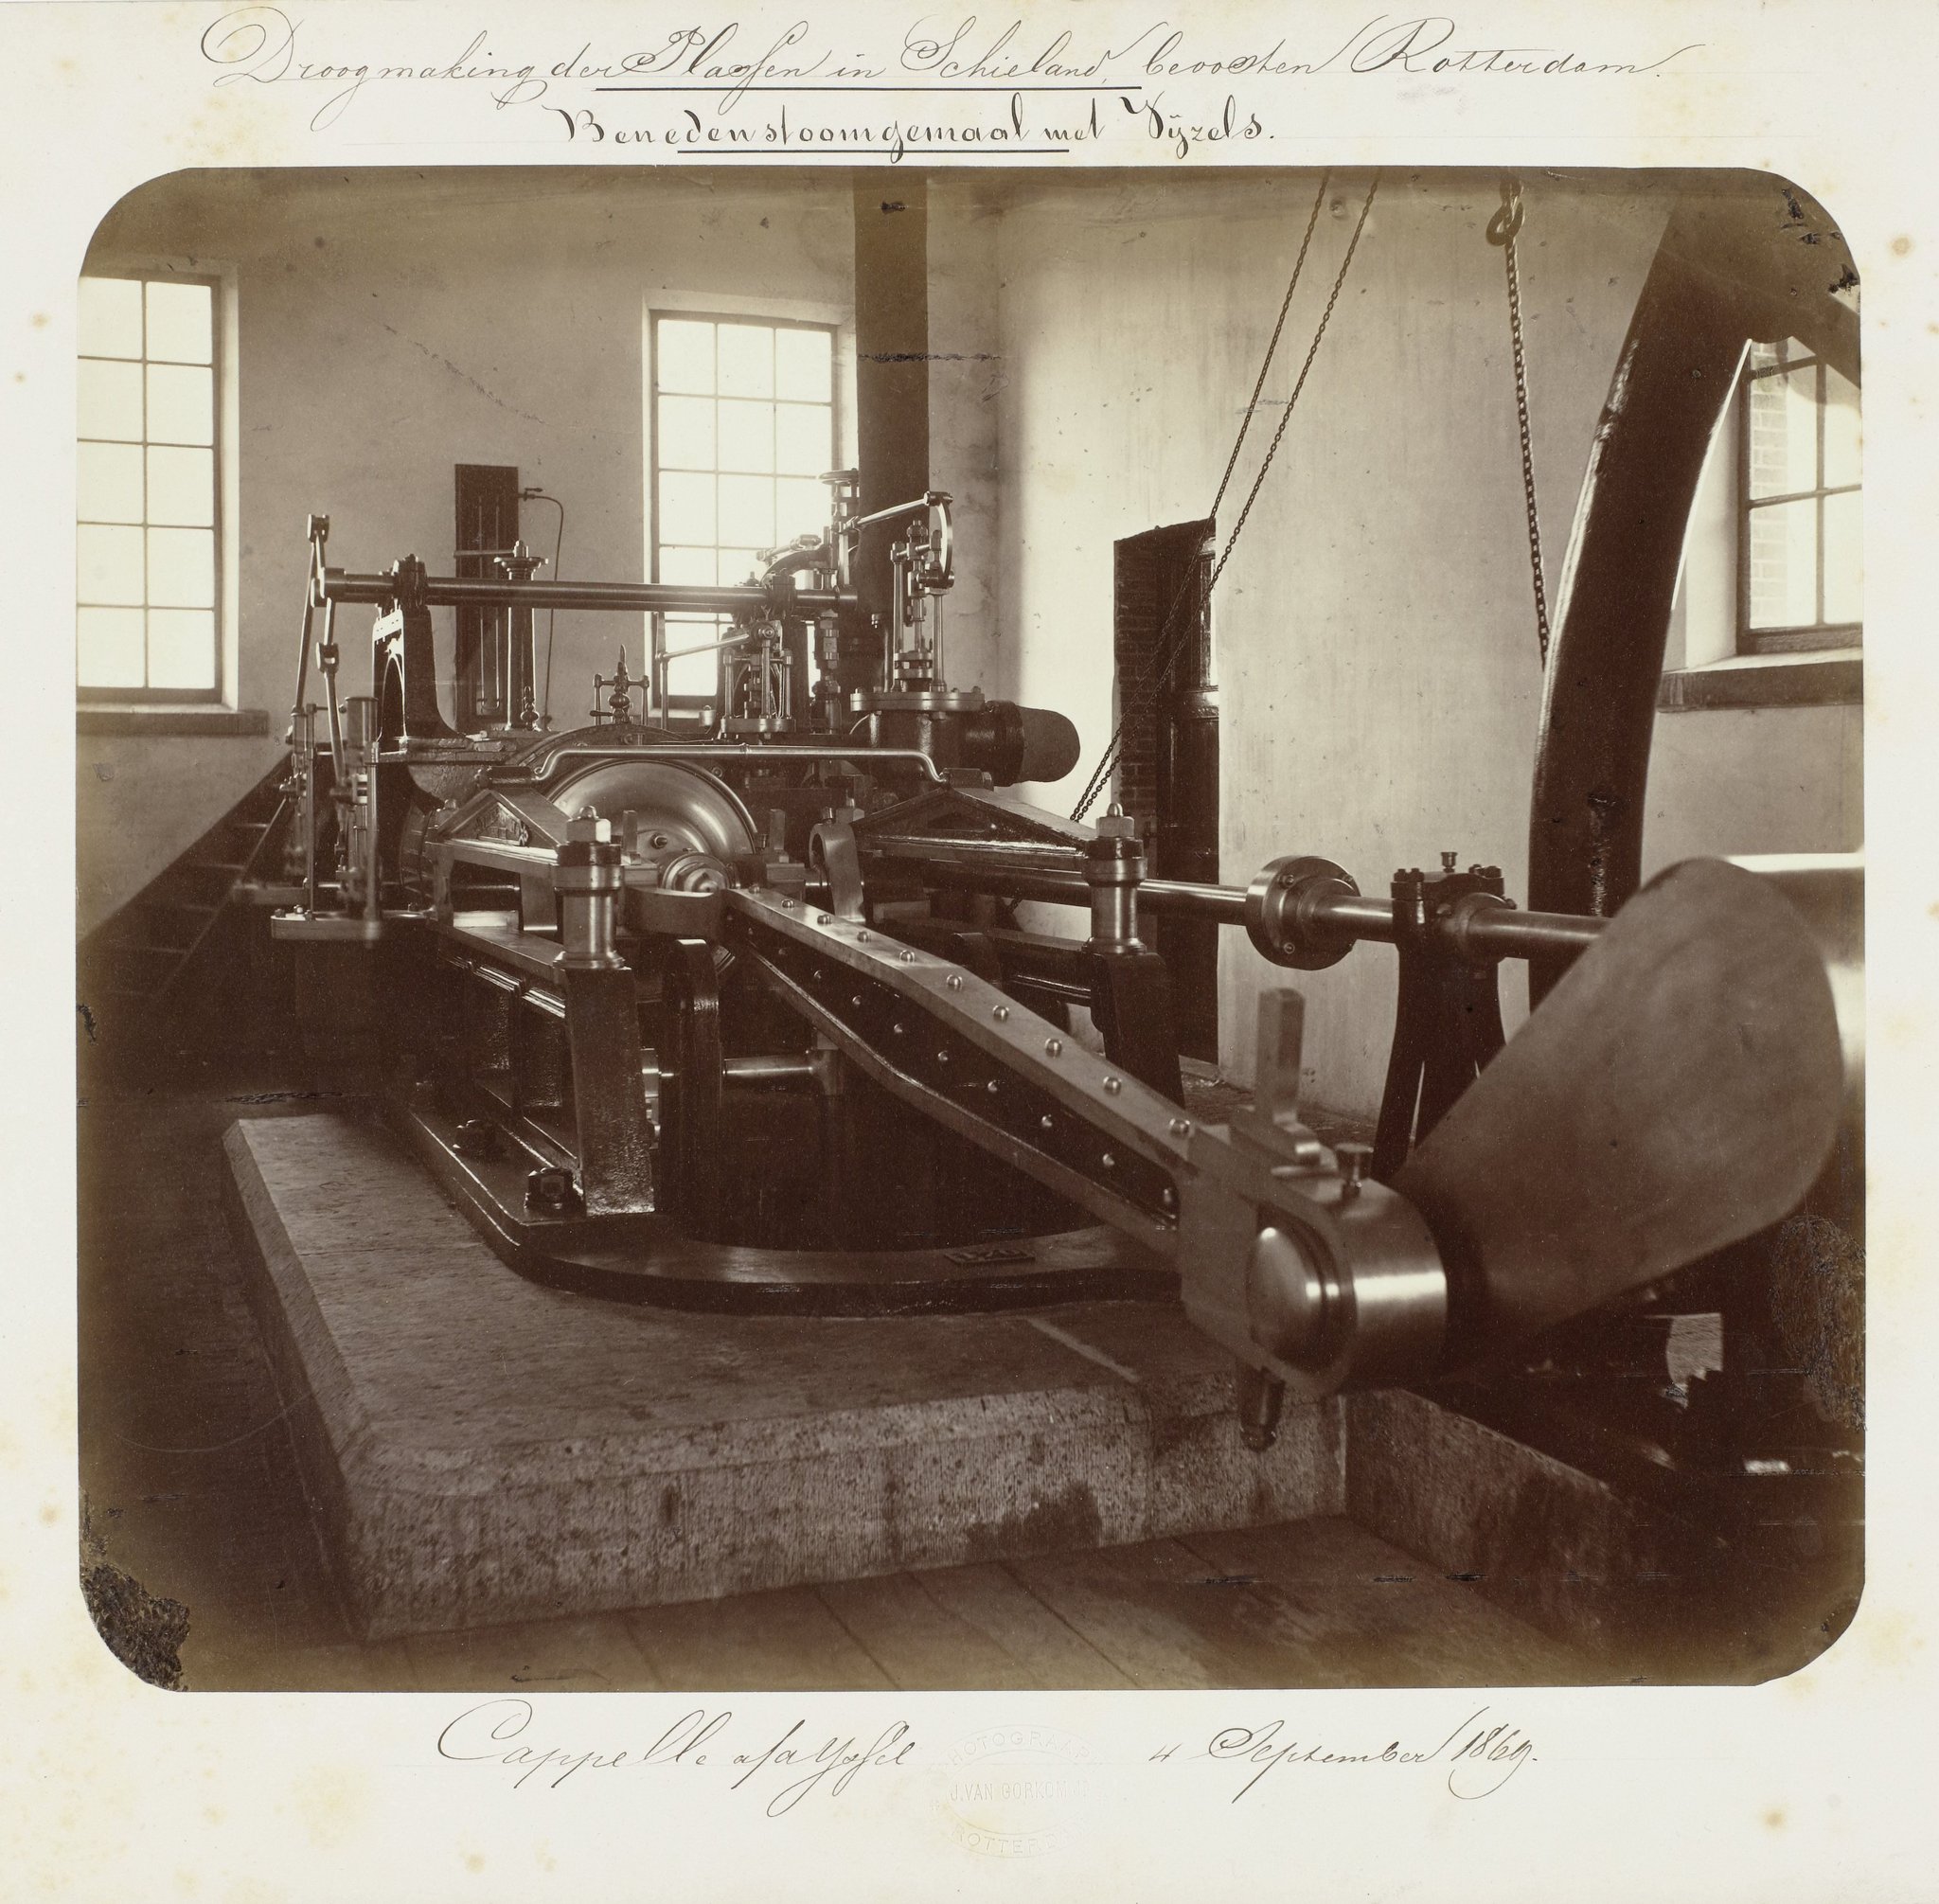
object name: photograph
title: Lower screw-driven pumping station, Capelle aan de IJssel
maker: jacobus van gorkom (jr.)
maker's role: print maker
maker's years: 1827-1880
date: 1869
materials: cardboard, paper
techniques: albumen print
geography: rotterdam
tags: rotterdam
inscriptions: date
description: These iron machines were marvels of modern technology in their day, and made it possible to drain and keep Holland’s polders dry. The machines are presented as showpieces in these government-commissioned photos. To drain the lakes east of Rotterdam, engineers dug a canal and a peripheral waterway to flush away the water. Then they extracted the water with pumps at Kralingen, Capelle and Nieuwerkerk.